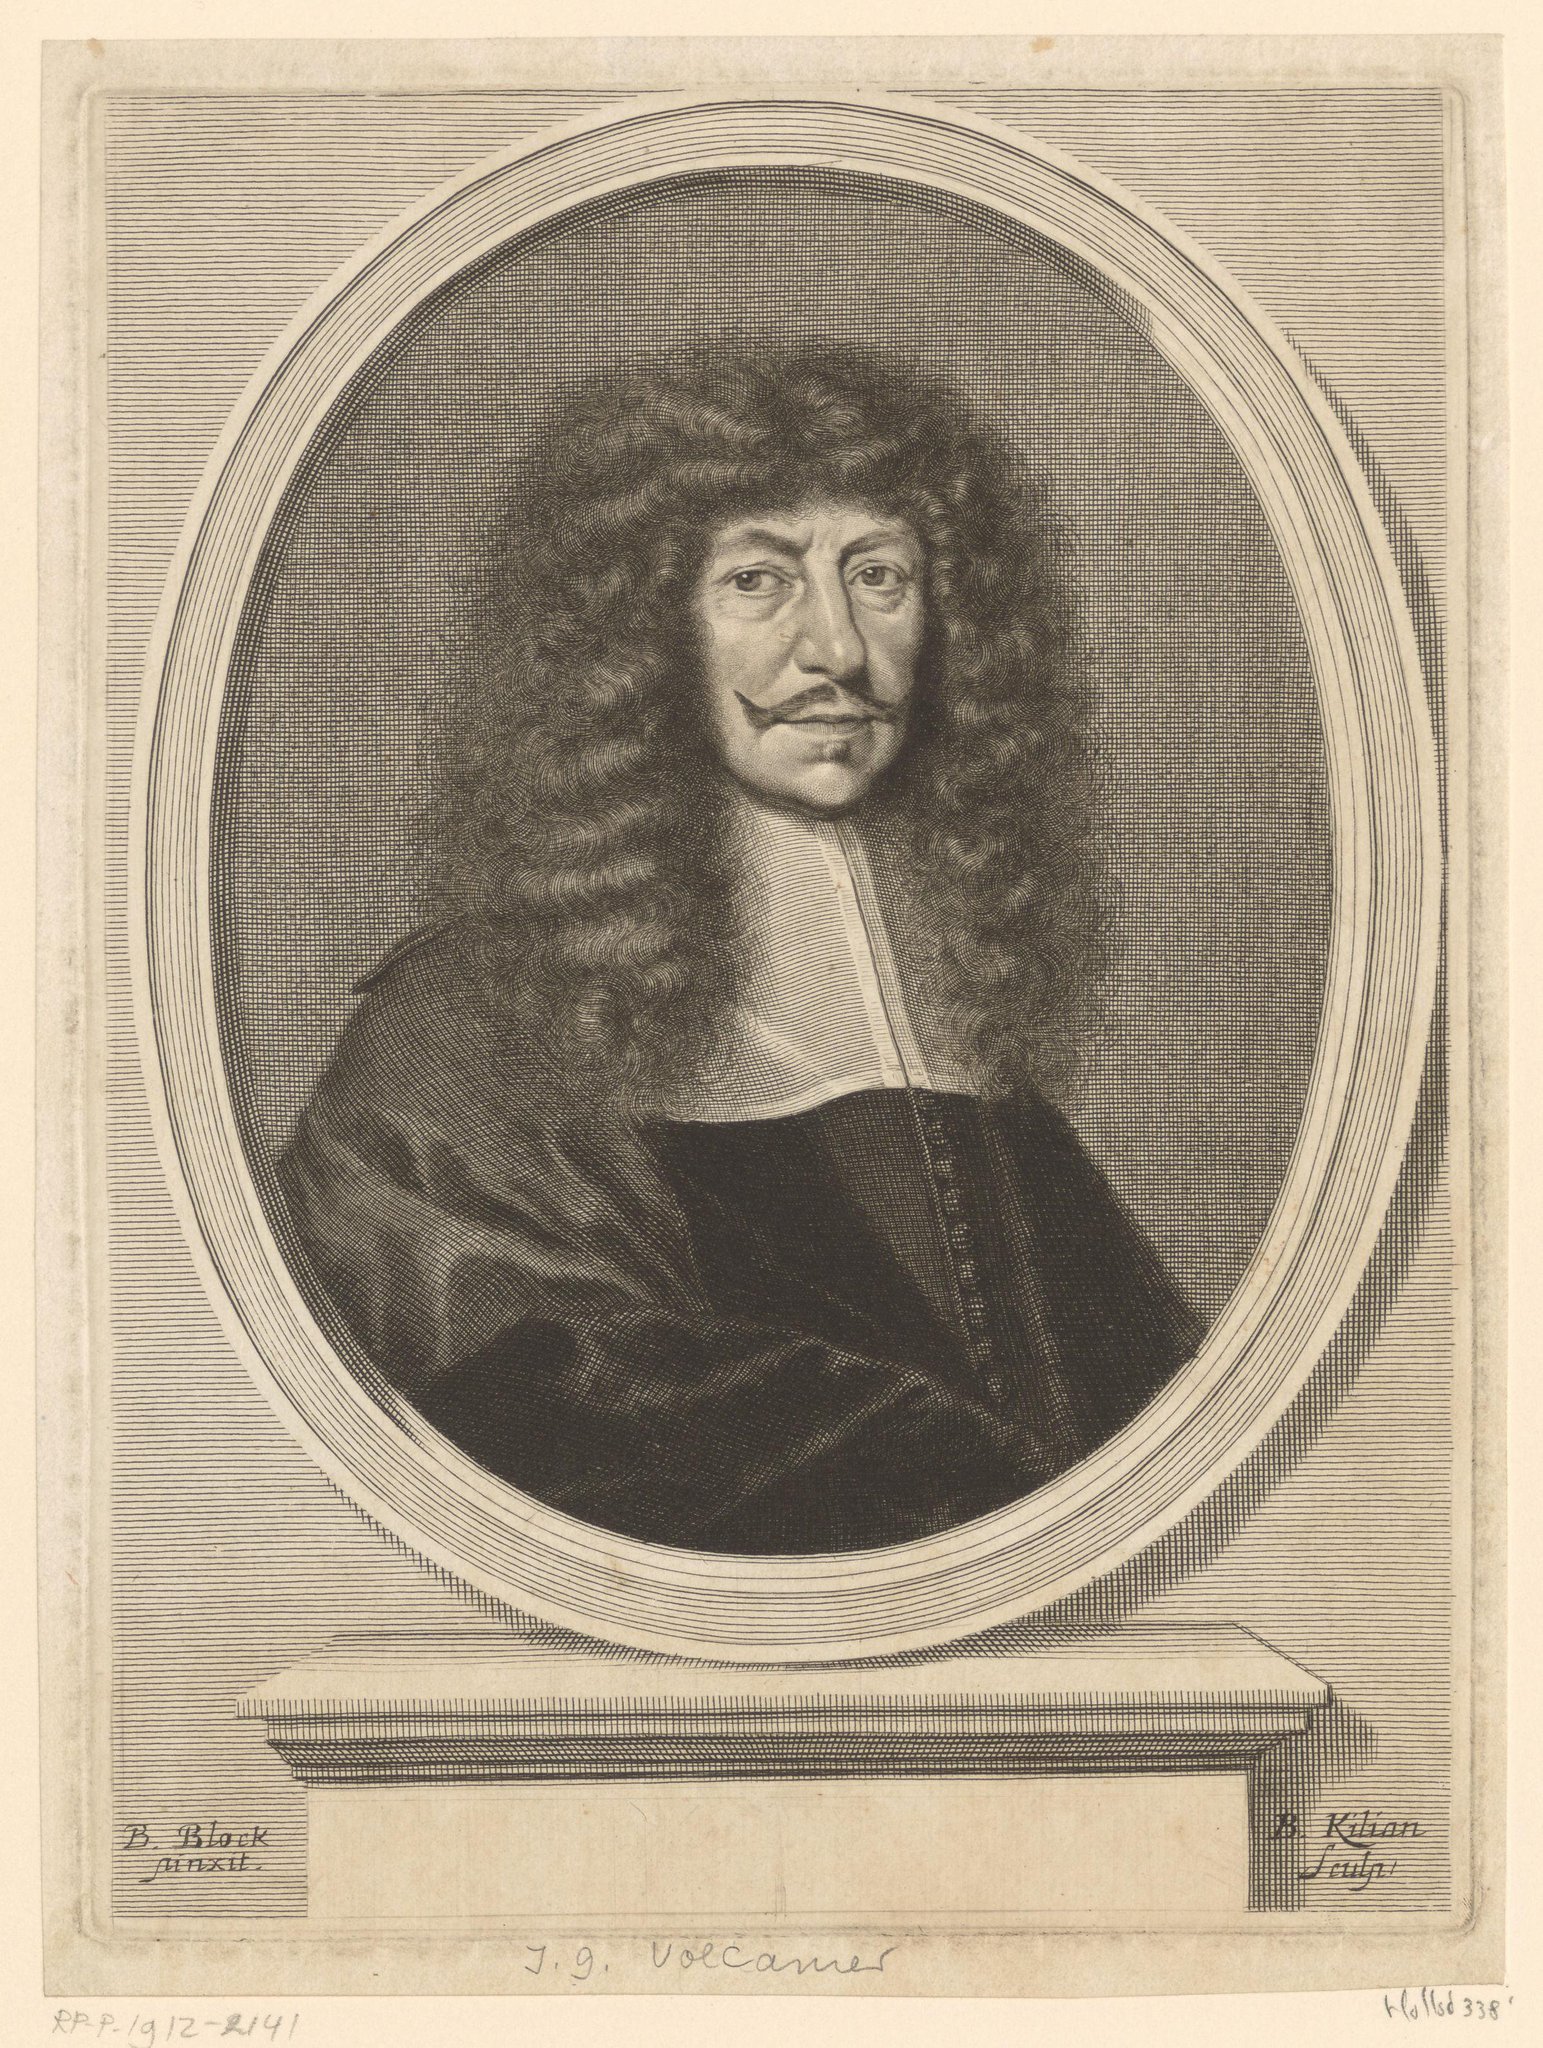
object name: print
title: Portret van Johann Georg Volckamer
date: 1640-1696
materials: paper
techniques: engraving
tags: johann georg volckamer (i), historical persons, physician, doctor (+ portrait of scholar, scientist)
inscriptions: collector's mark: Lugt 2228